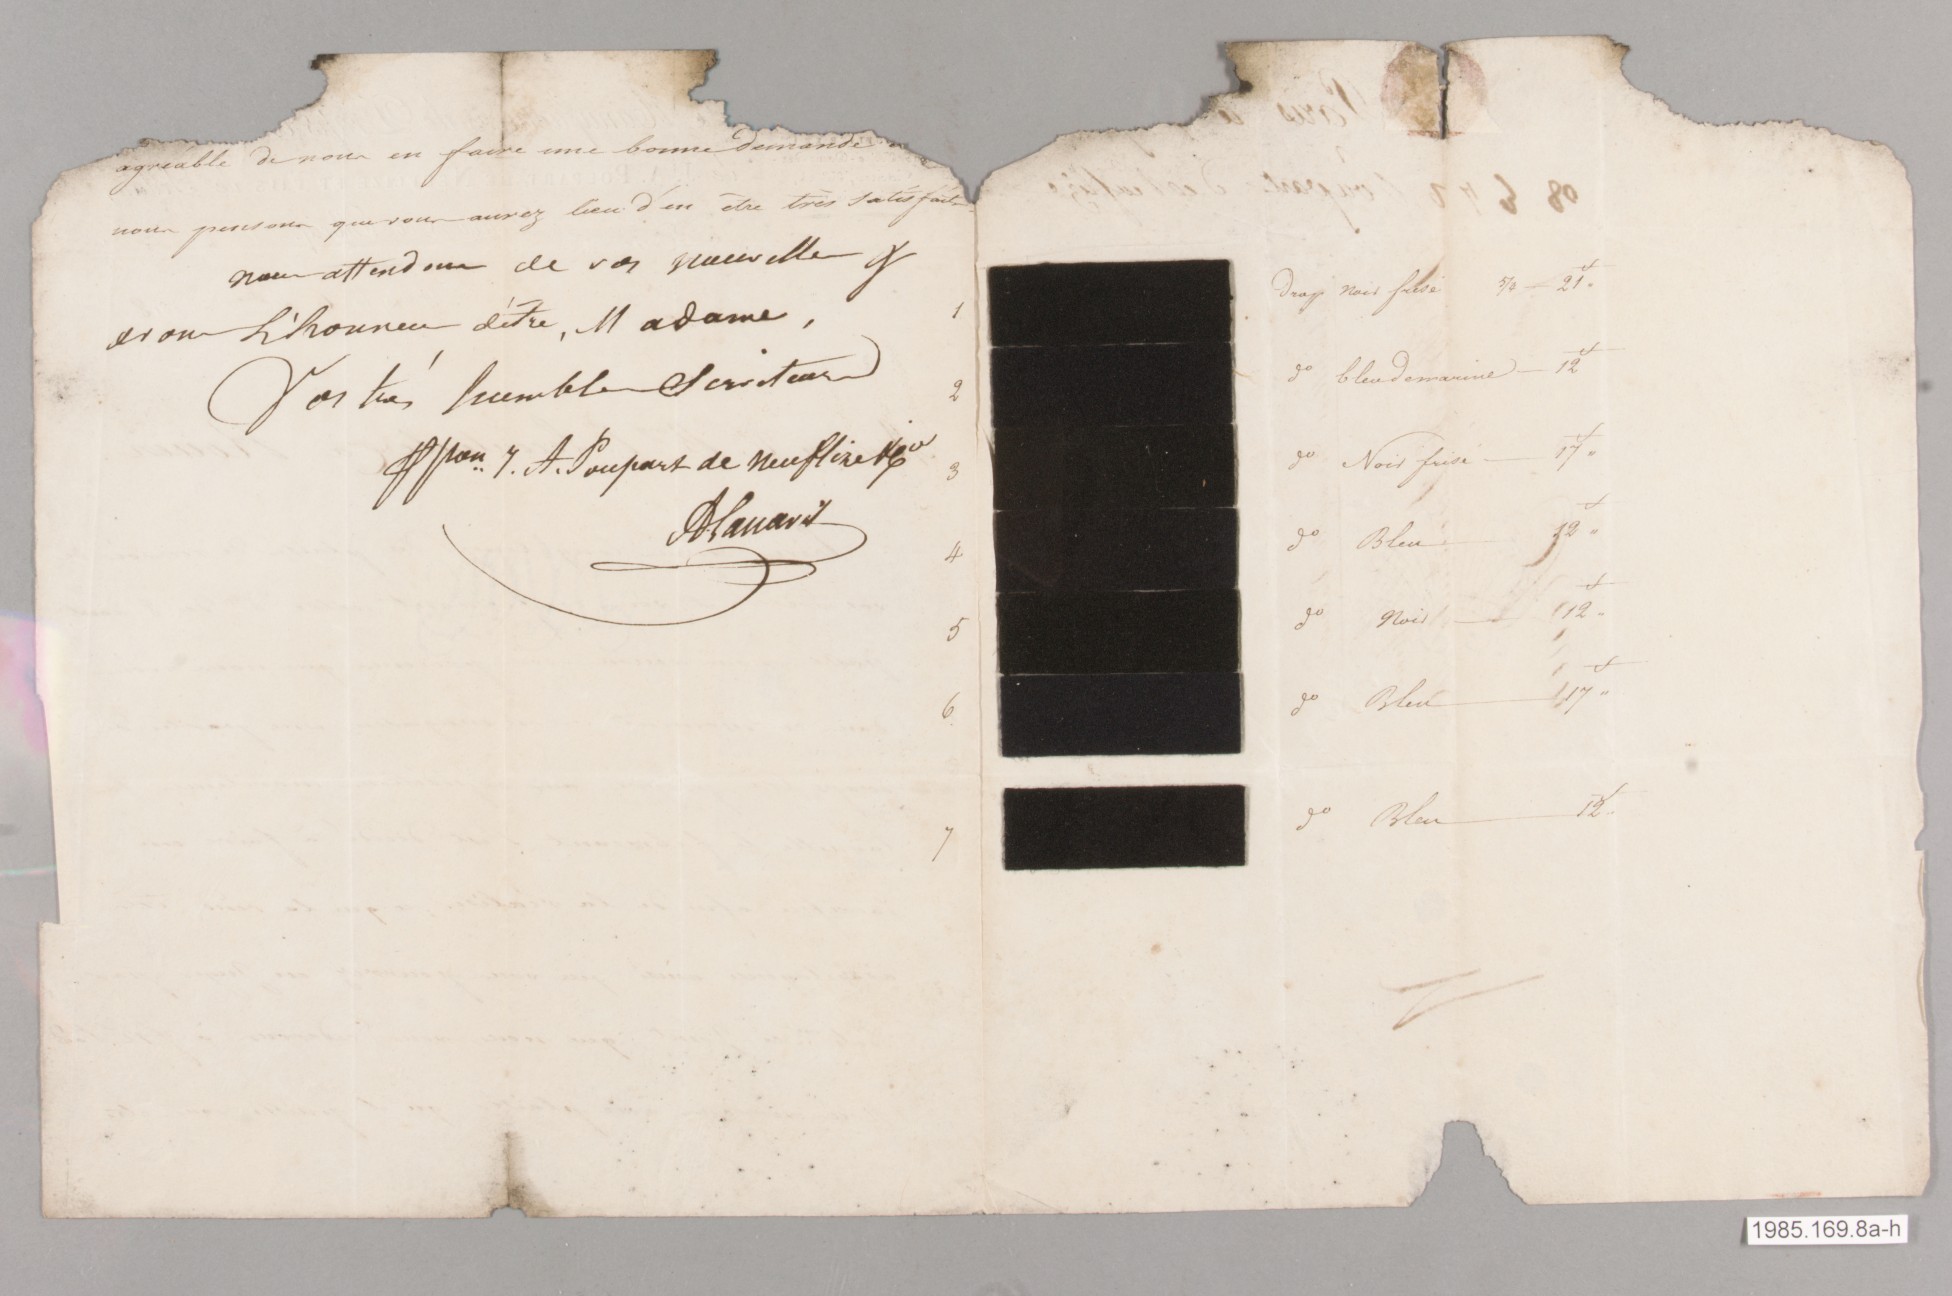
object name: letter with textile sample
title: Letter with textile samples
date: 1767-1833